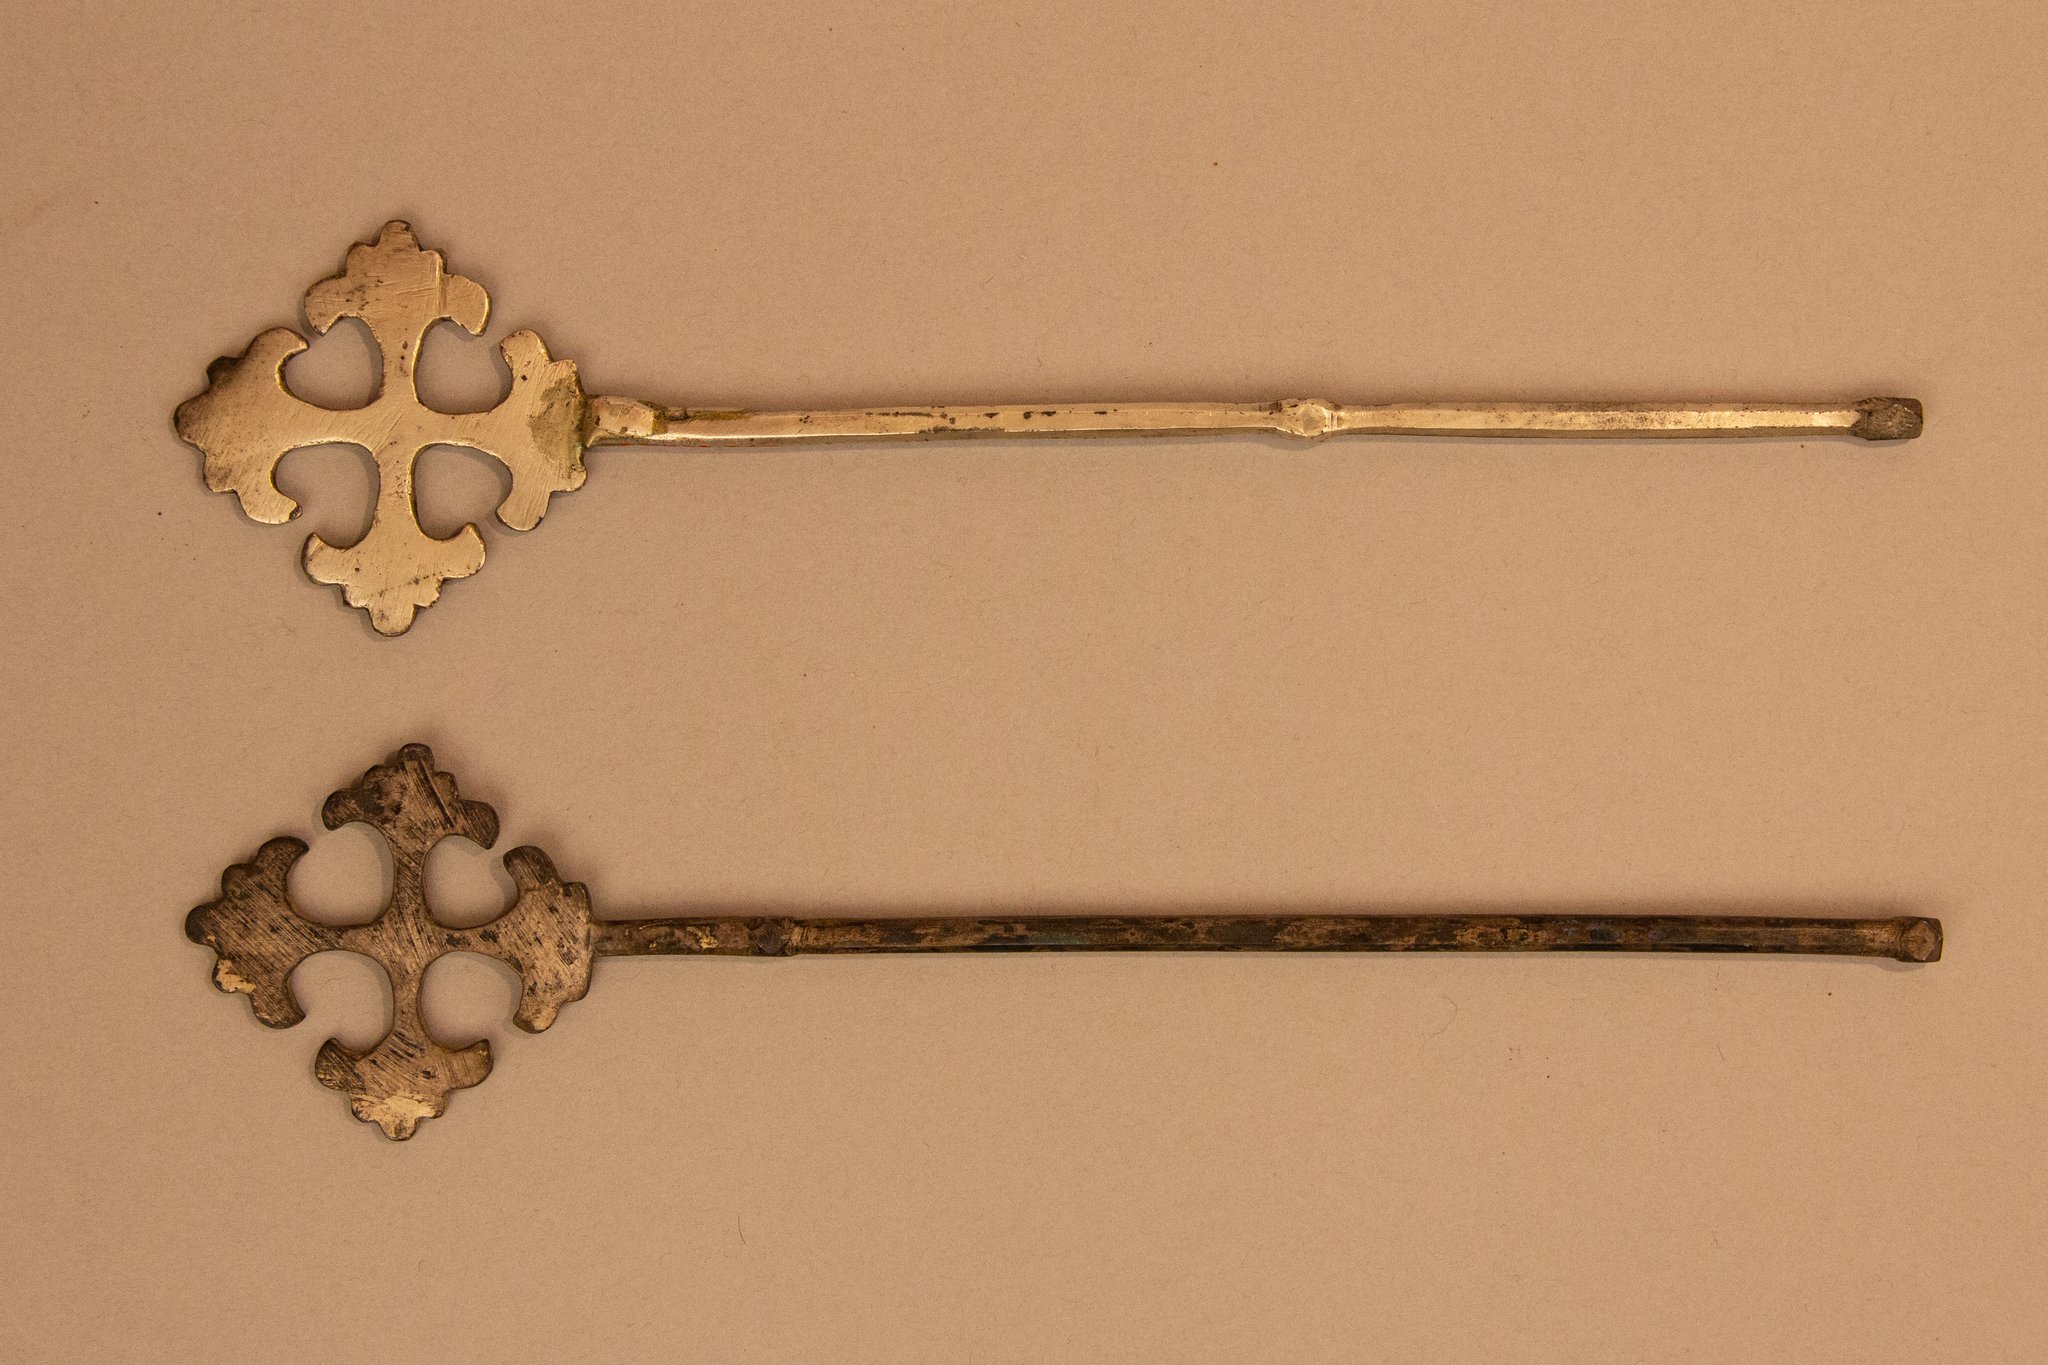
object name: cross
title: Crosses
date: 401-600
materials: silver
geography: egypt